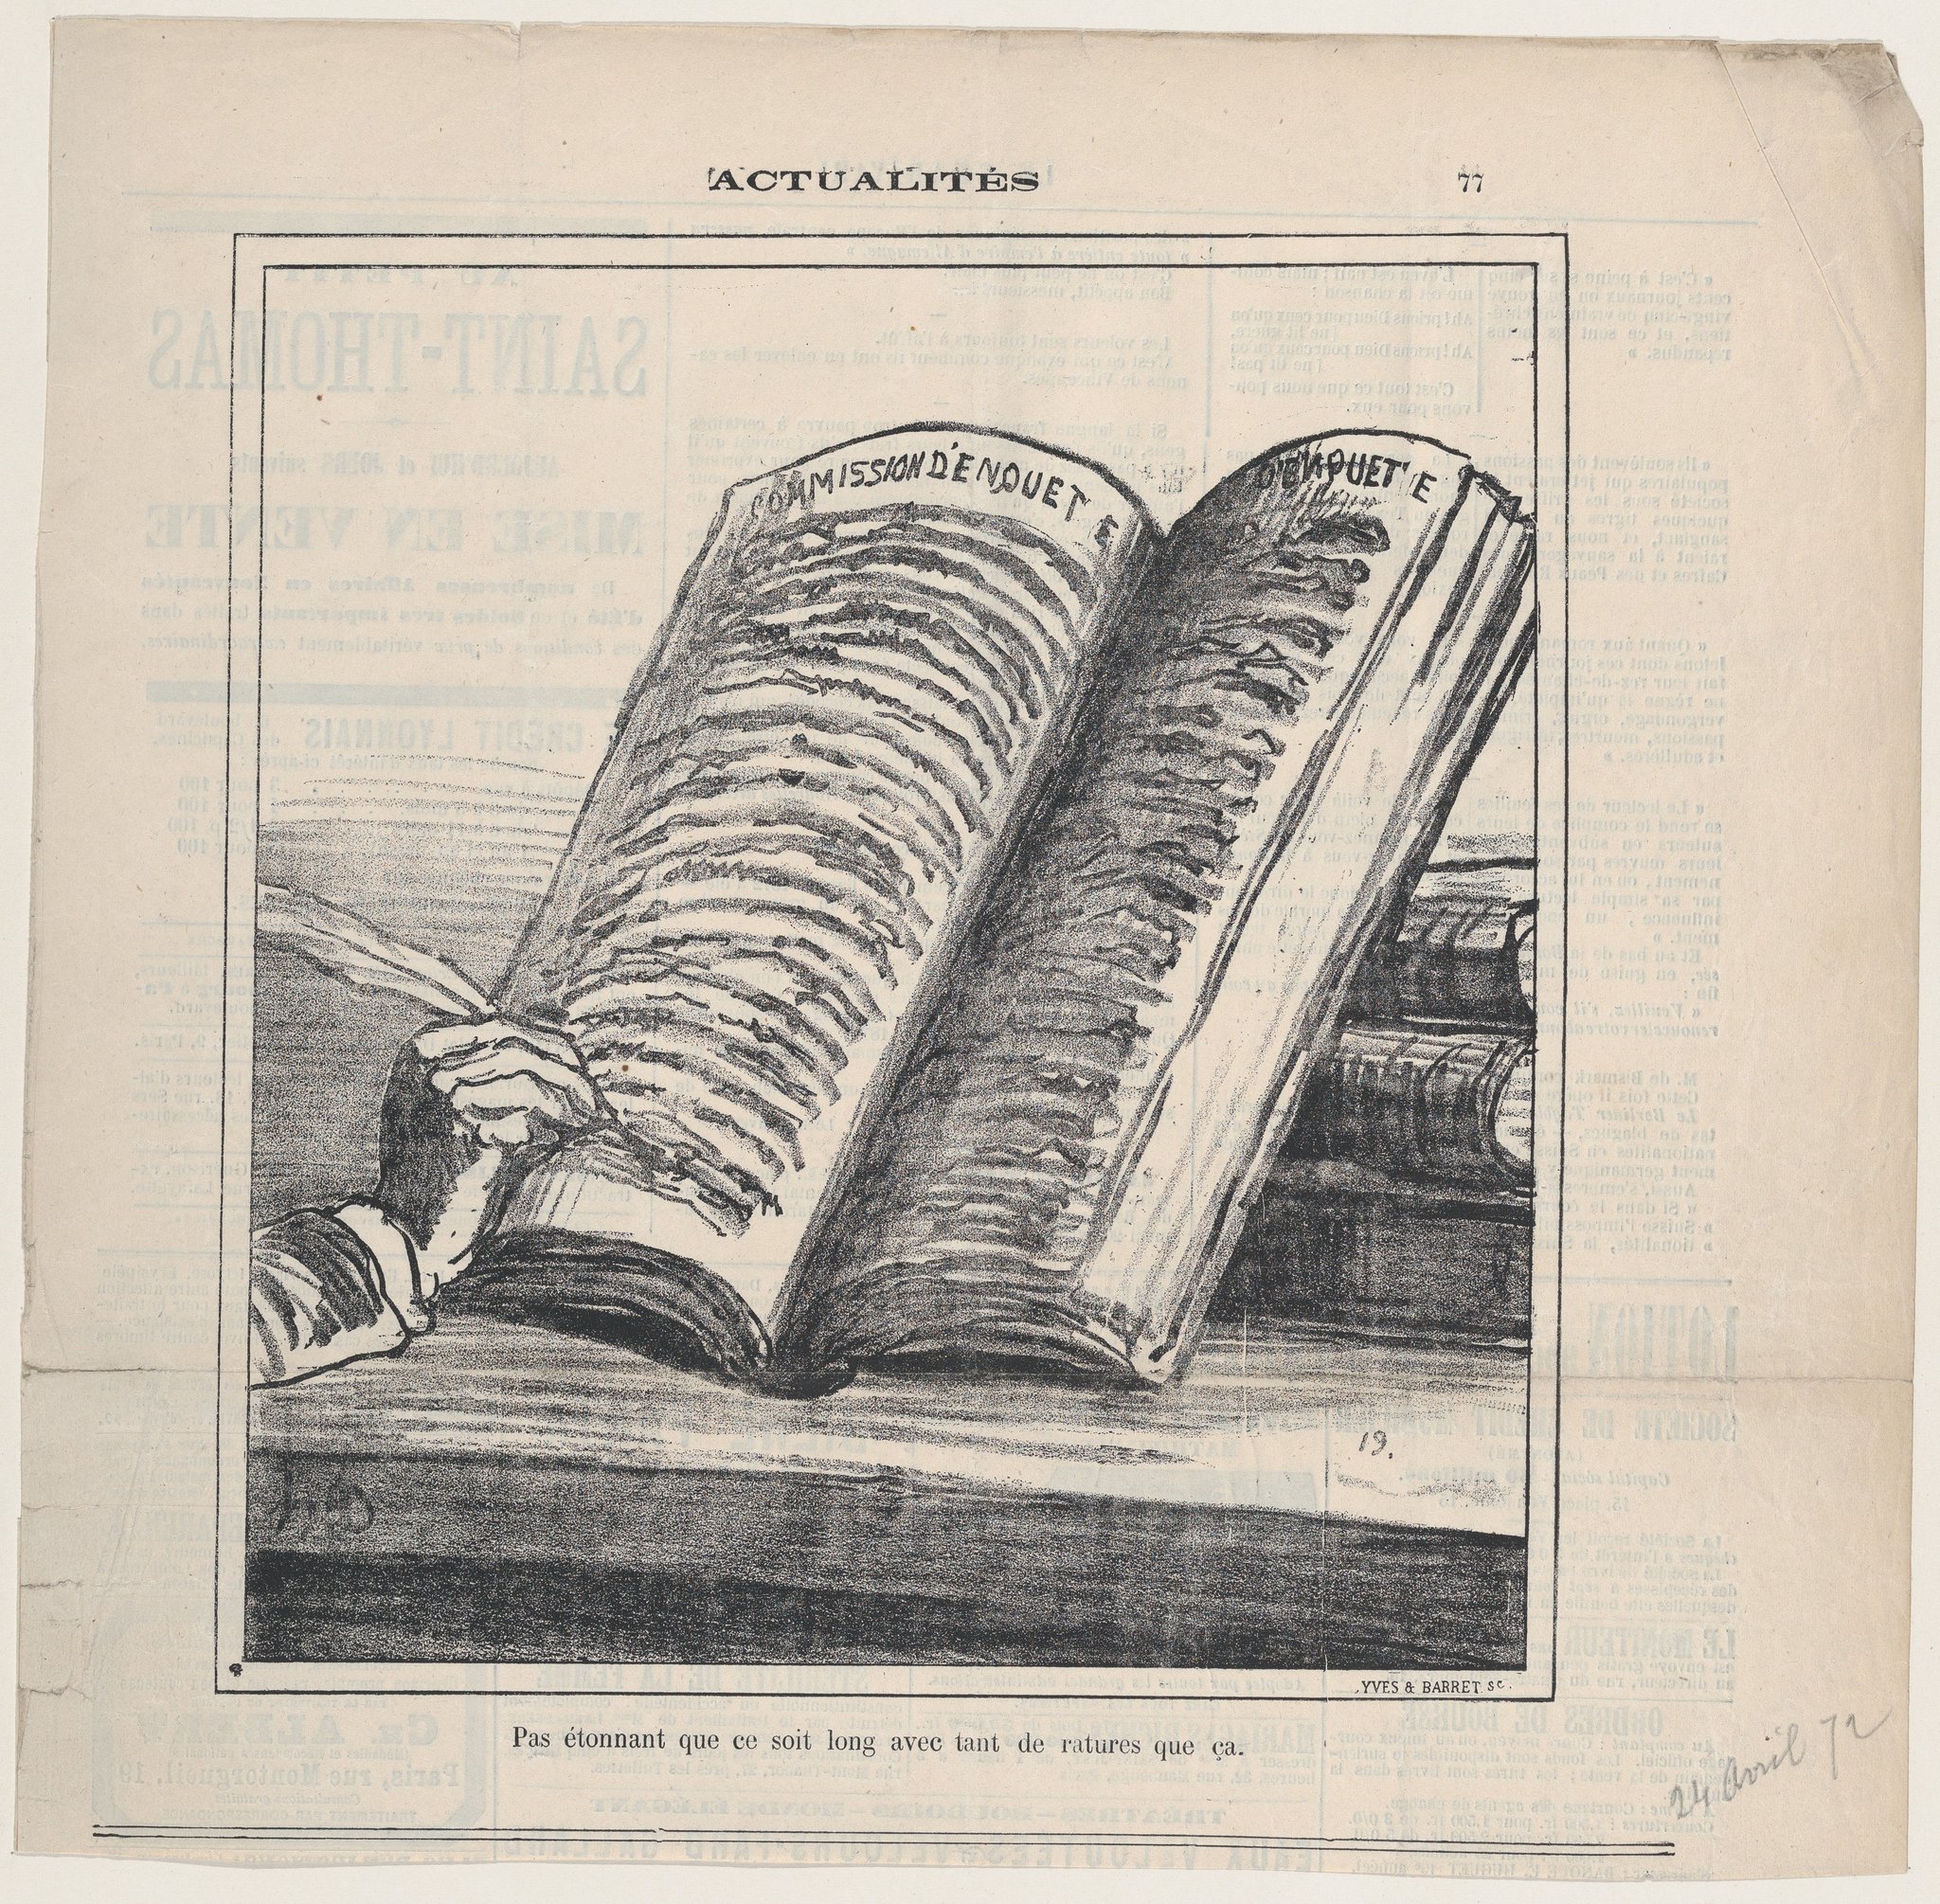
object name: print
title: Not surprising that it will be long with all these erasures, from 'News of the day,' published in Le Charivari, April 24, 1872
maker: honoré daumier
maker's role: artist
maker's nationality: french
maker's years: 1808-1879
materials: paper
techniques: lithograph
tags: hands,writing